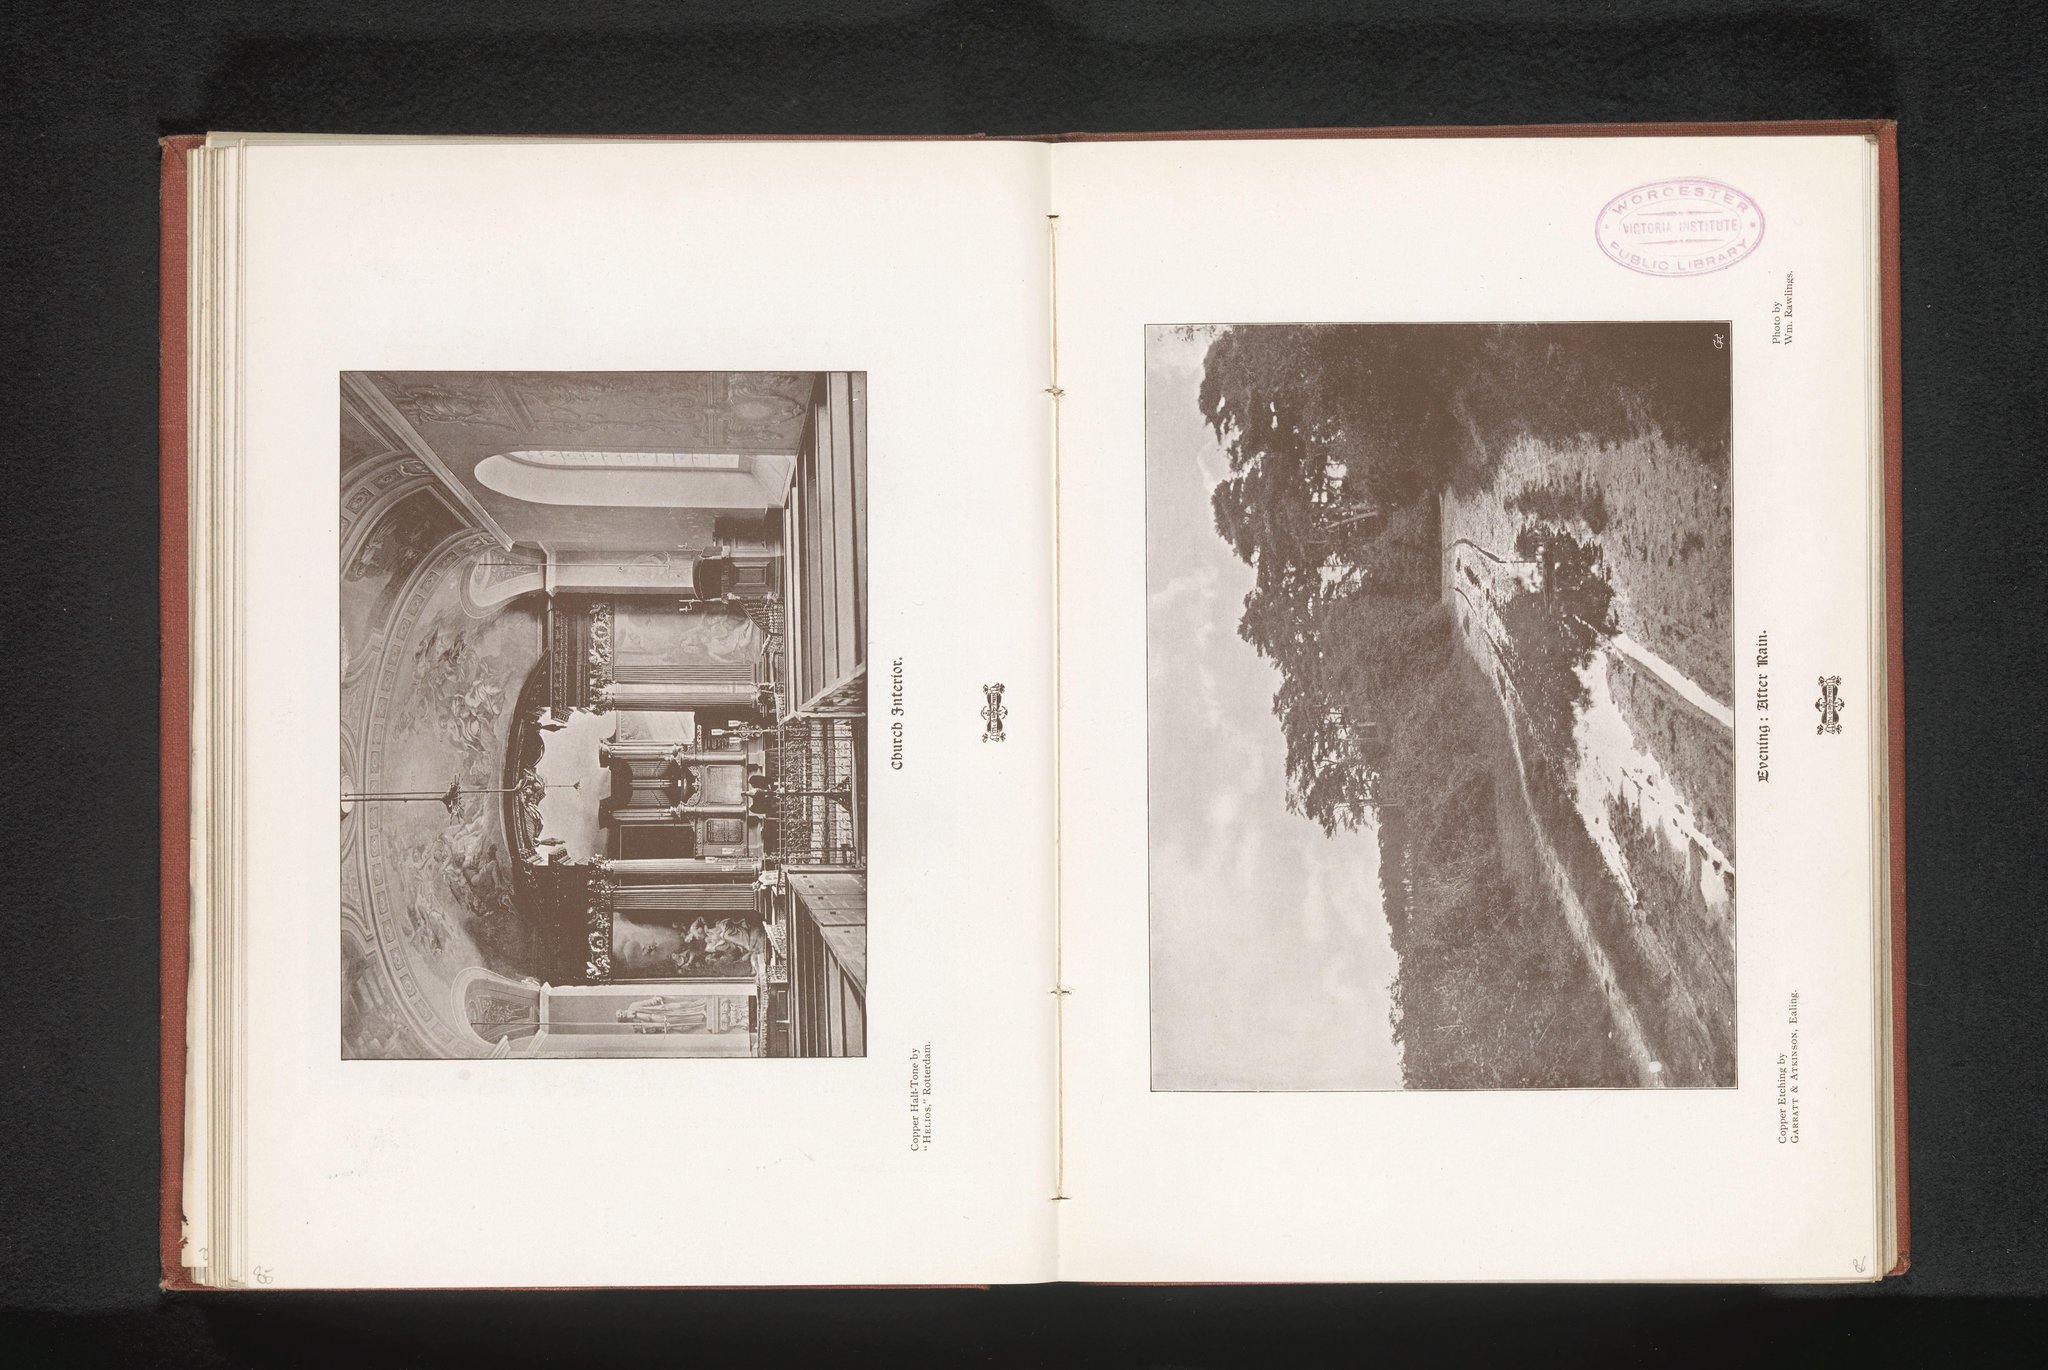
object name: page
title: Landschap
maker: w. rawlings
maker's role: fotograaf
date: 1895-1900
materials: paper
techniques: autotype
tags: landscapes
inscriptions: collector's mark: ‘Worcester Public Library/ Victoria Institute’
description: Prent op vijfde ongenummerde pagina na pagina 68.